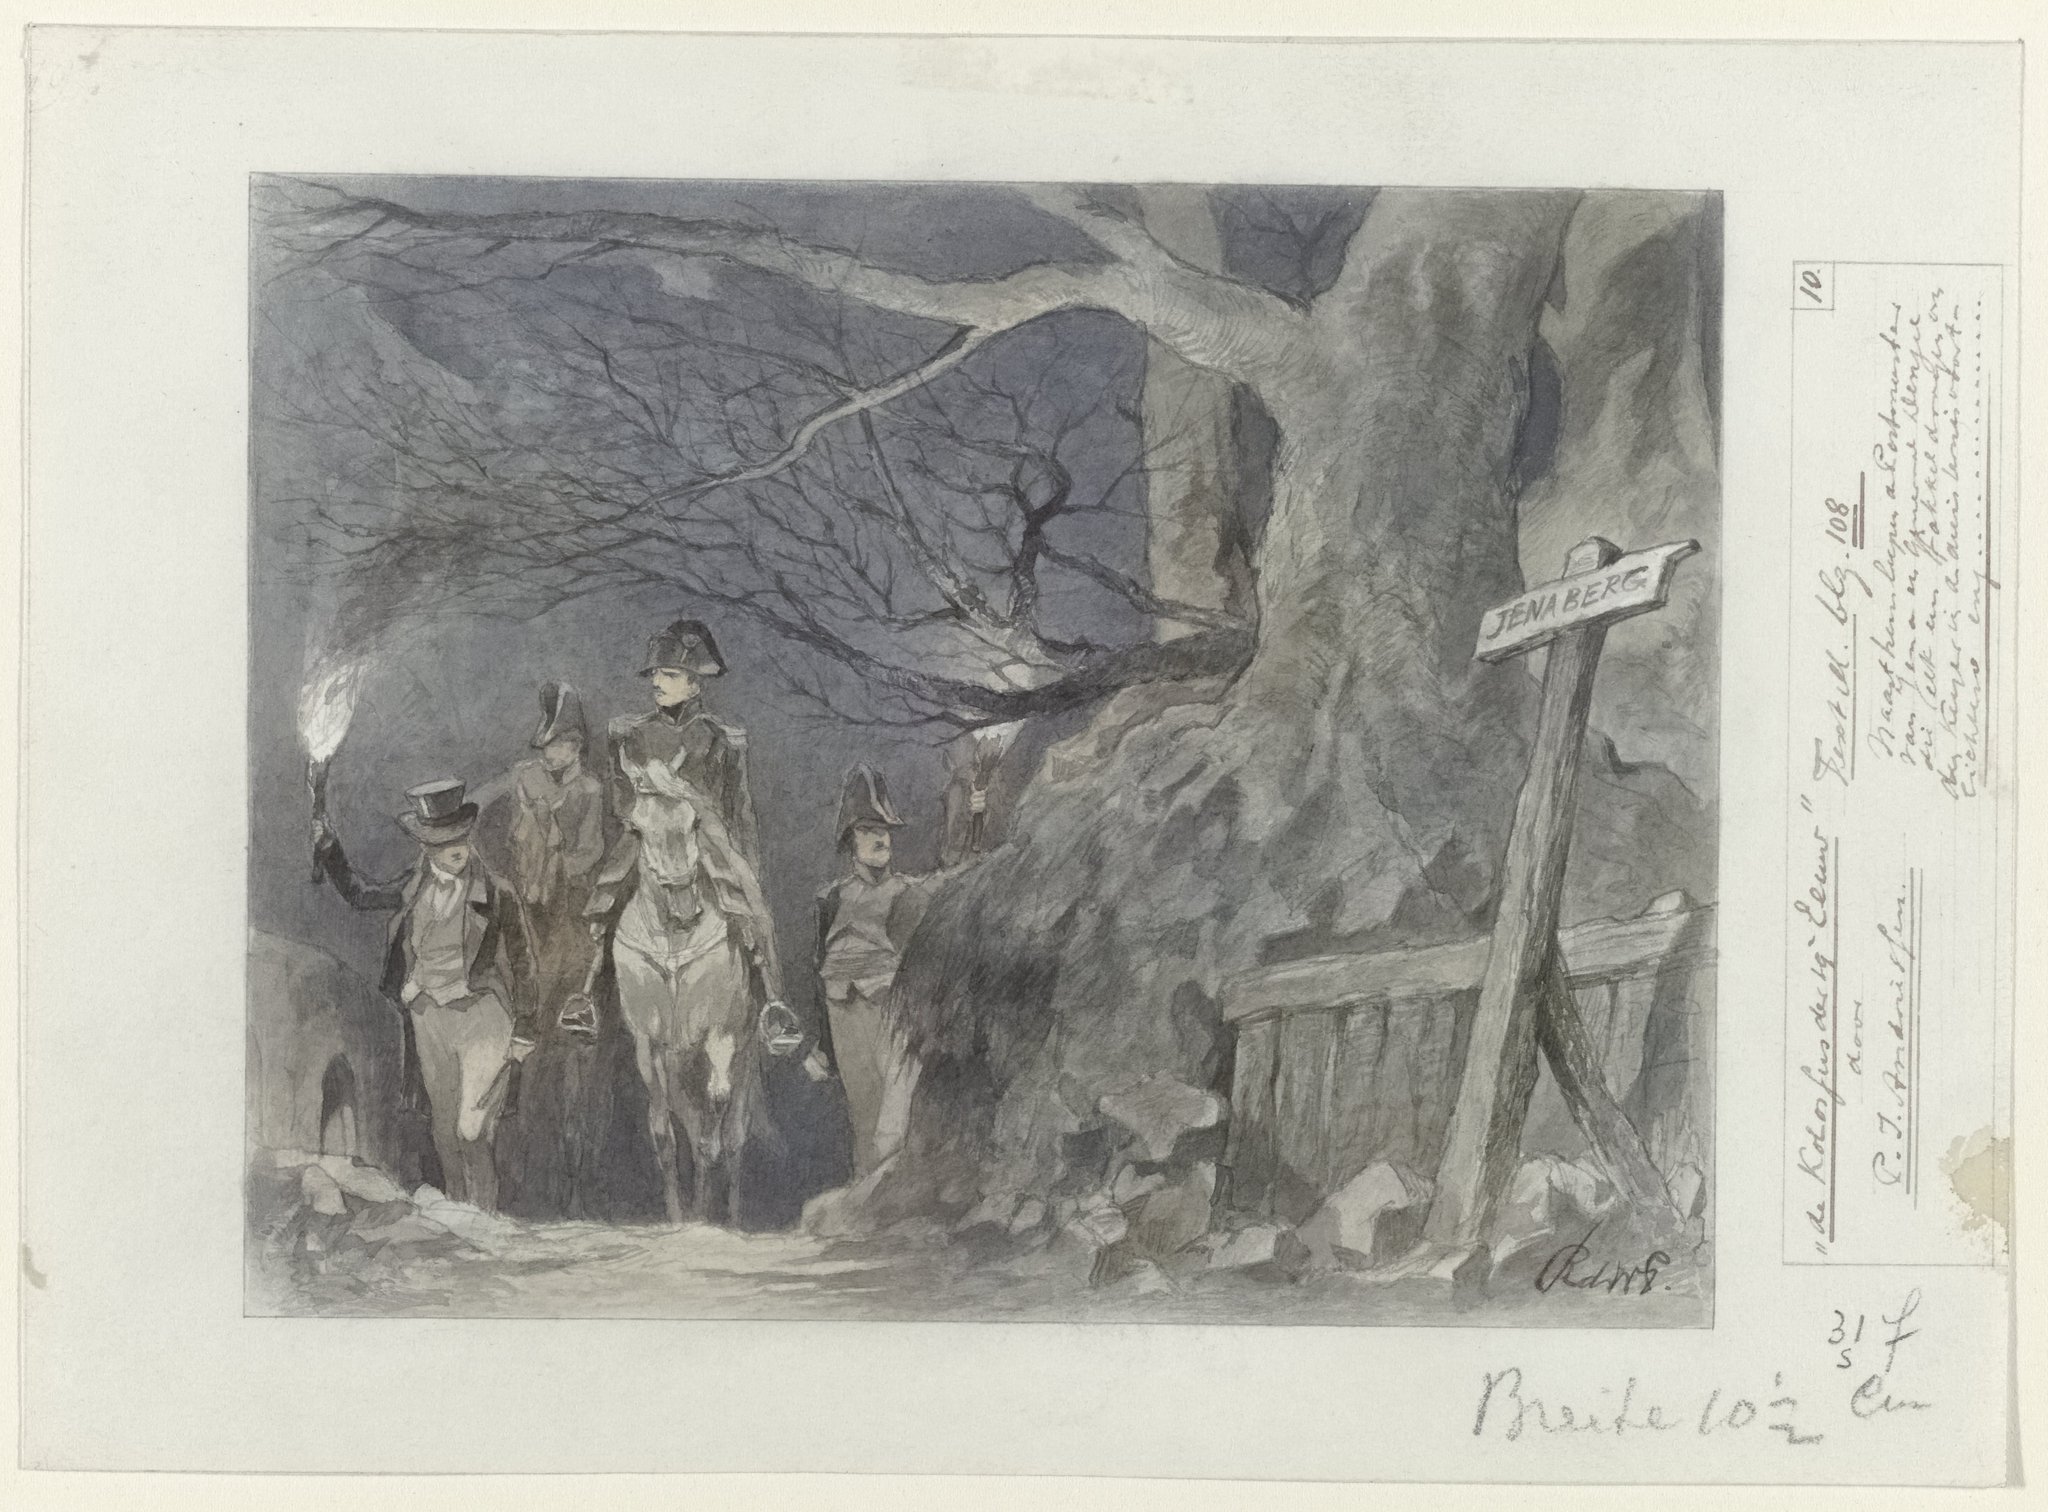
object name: drawing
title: Ontwerp voor illustratie voor De Kolossus der Negentiende Eeuw door P.J. Andriessen (Textill., blz. 108); scène uit het leven van Napoleon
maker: george lodewijk de wetstein pfister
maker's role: draughtsman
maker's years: 1867-1942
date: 1877-1942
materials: ink, paper, pencil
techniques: brush, pen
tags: napoleon i (emperor of the french), (andriessen, de kolossus der negentiende eeuw) specific works of literature (with author, title), historical persons, illustration ~ printed matter, book, historical events and situations